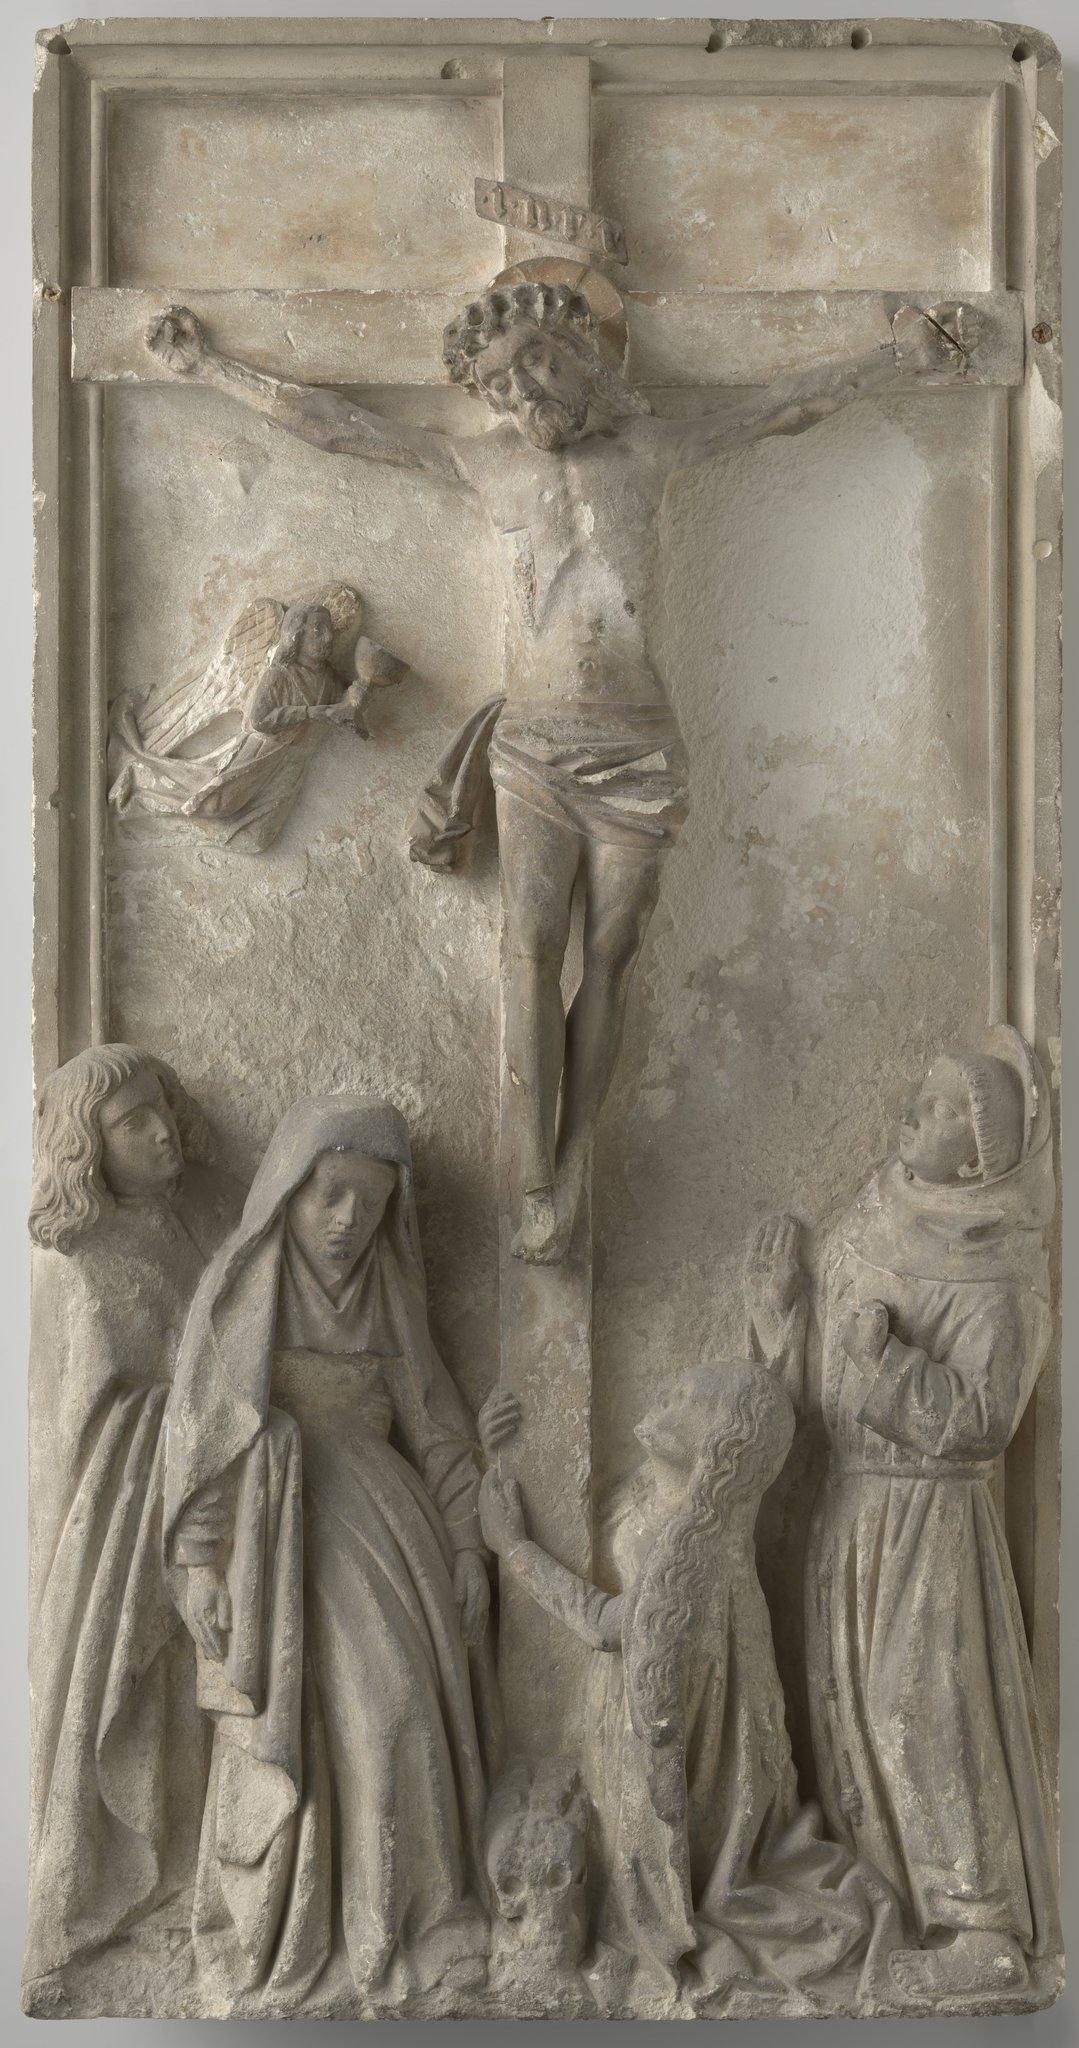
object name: sculpture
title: Christ on the Cross with the Virgin, St John, Mary Magdalene and St Francis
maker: Anonymous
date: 1475-1500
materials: limestone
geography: burgundy